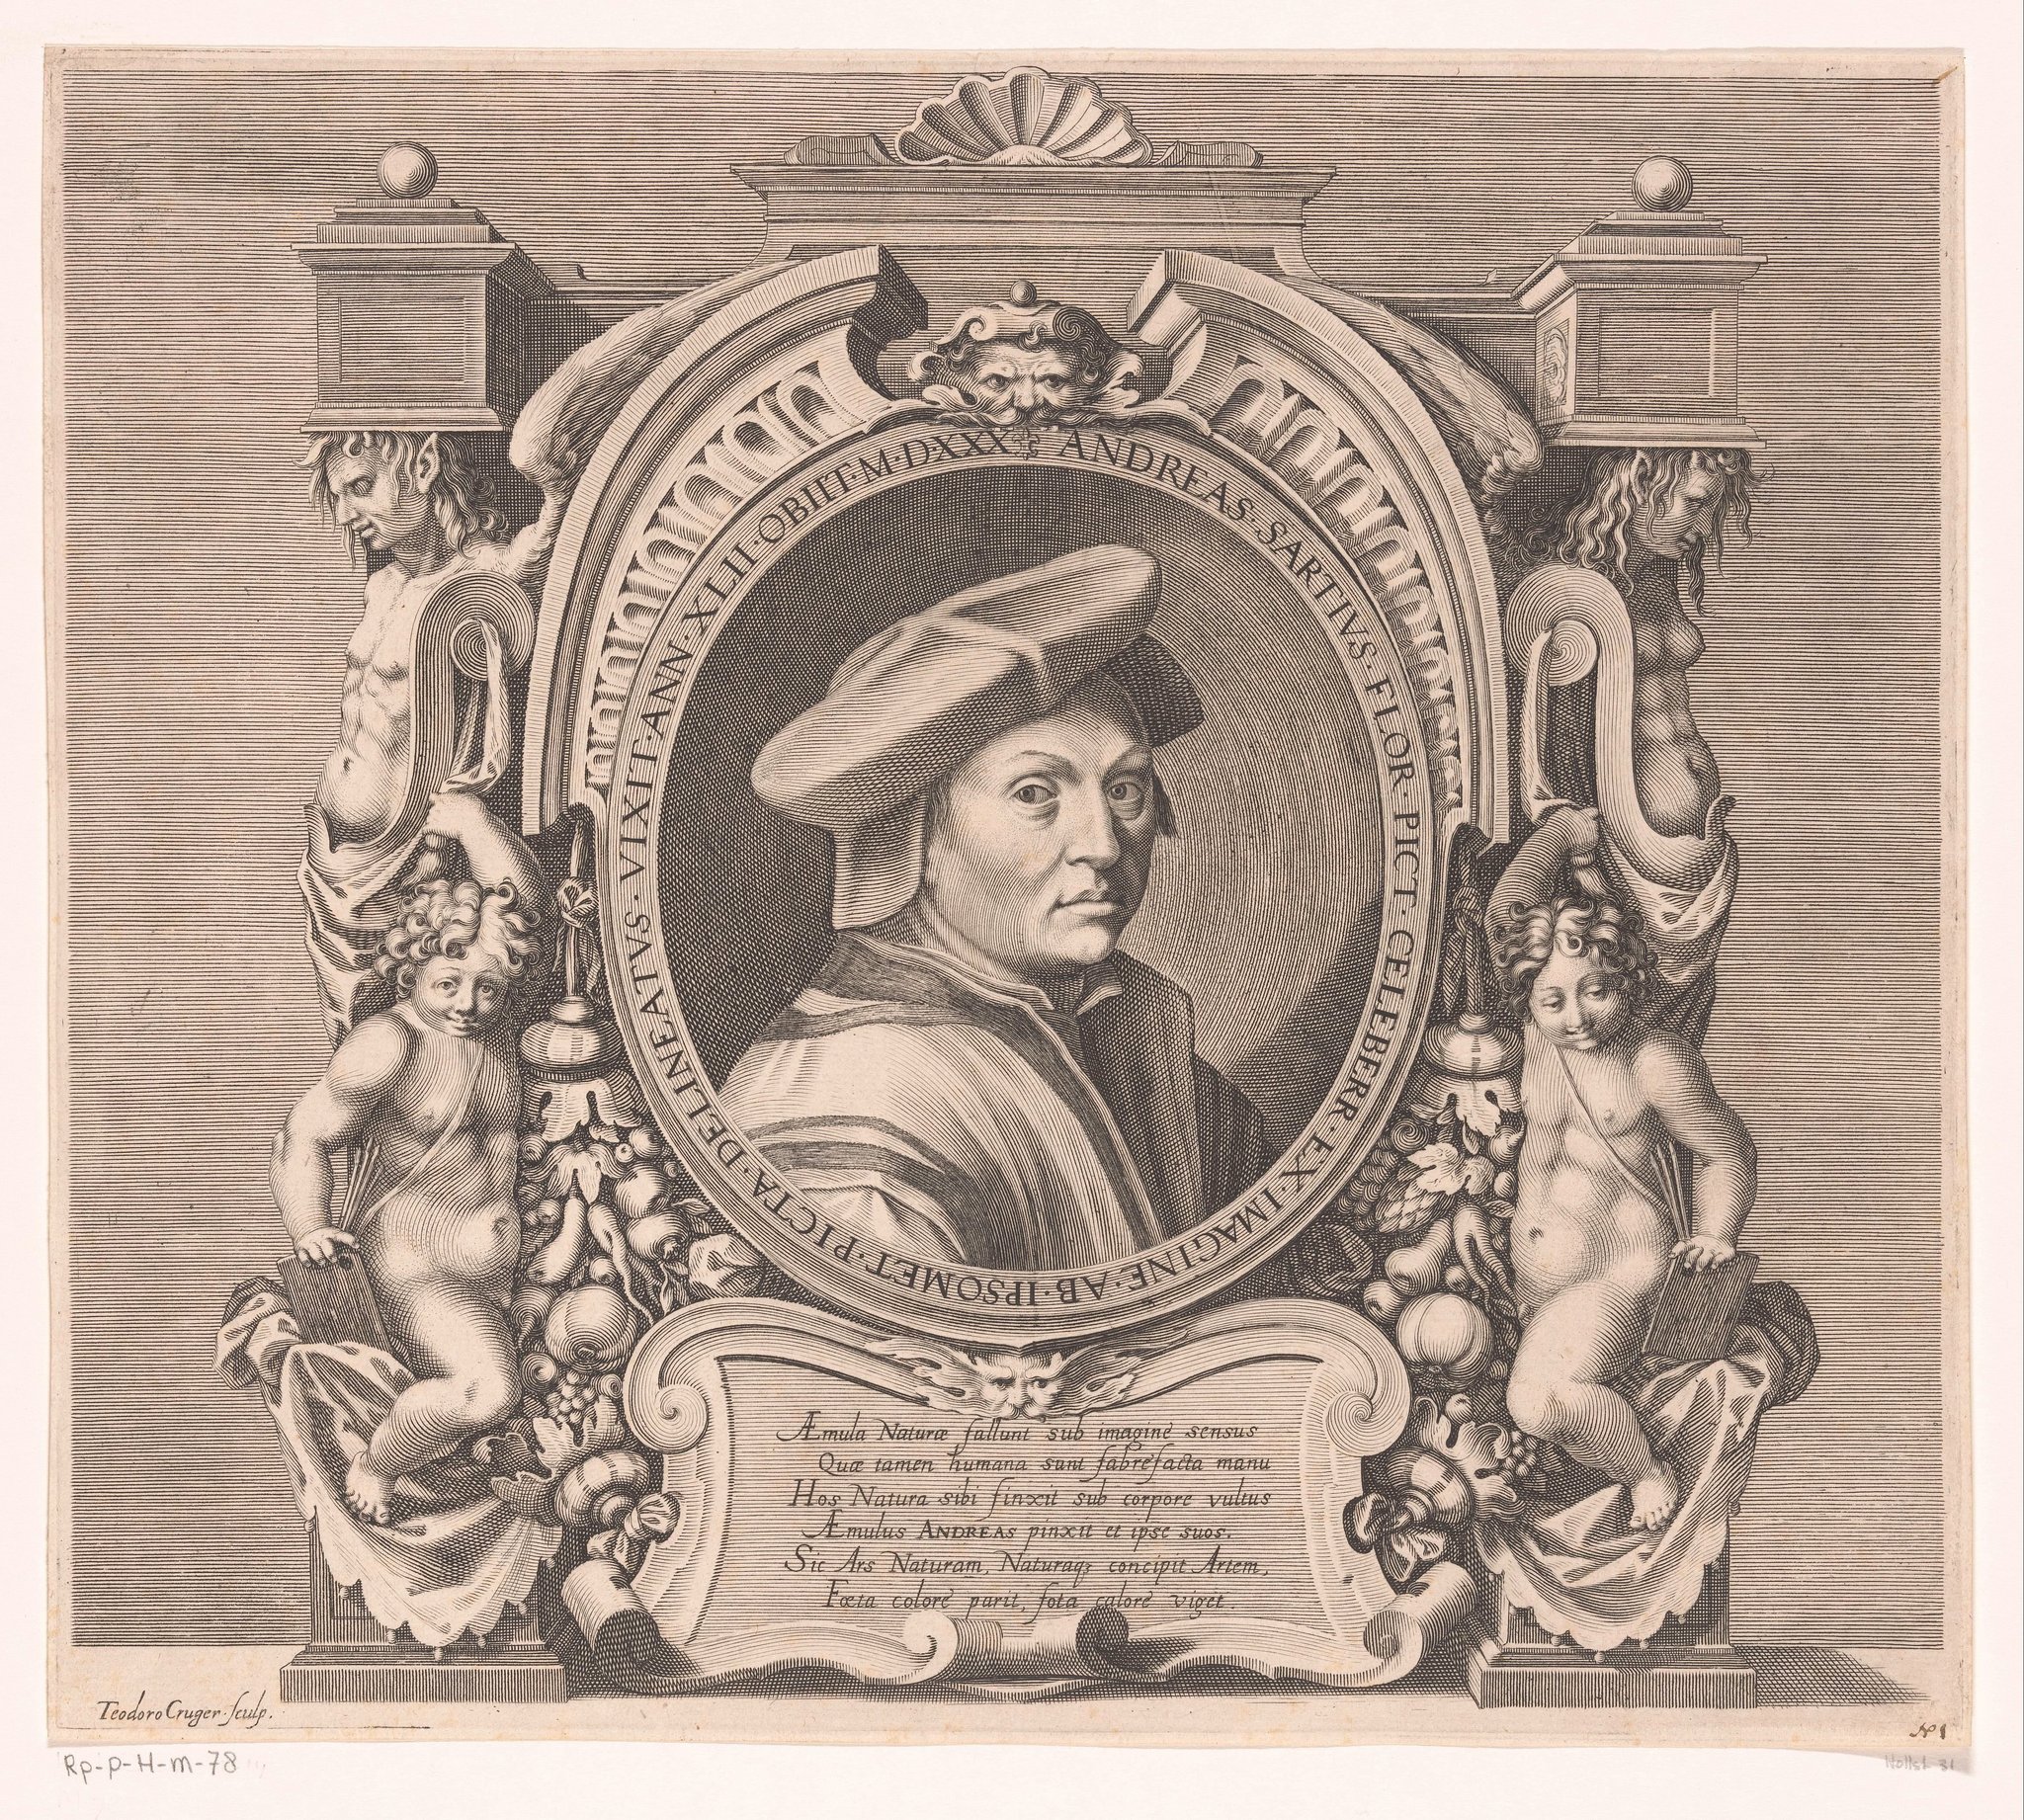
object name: print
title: Portret van Andrea del Sarto op 42-jarige leeftijd in geornamenteerde omlijsting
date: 1617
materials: paper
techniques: engraving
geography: florence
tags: painter, draughtsman, andrea del sarto, caryatids ~ architecture, portrait, self-portrait of painter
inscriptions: collector's mark: Lugt 11, collector's mark: ‘Hinloopen’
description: Onderdeel van een serie van dertien prenten en een titelprent. Origineel onderdeel geweest van het album Schijnvoet-nummer 24.